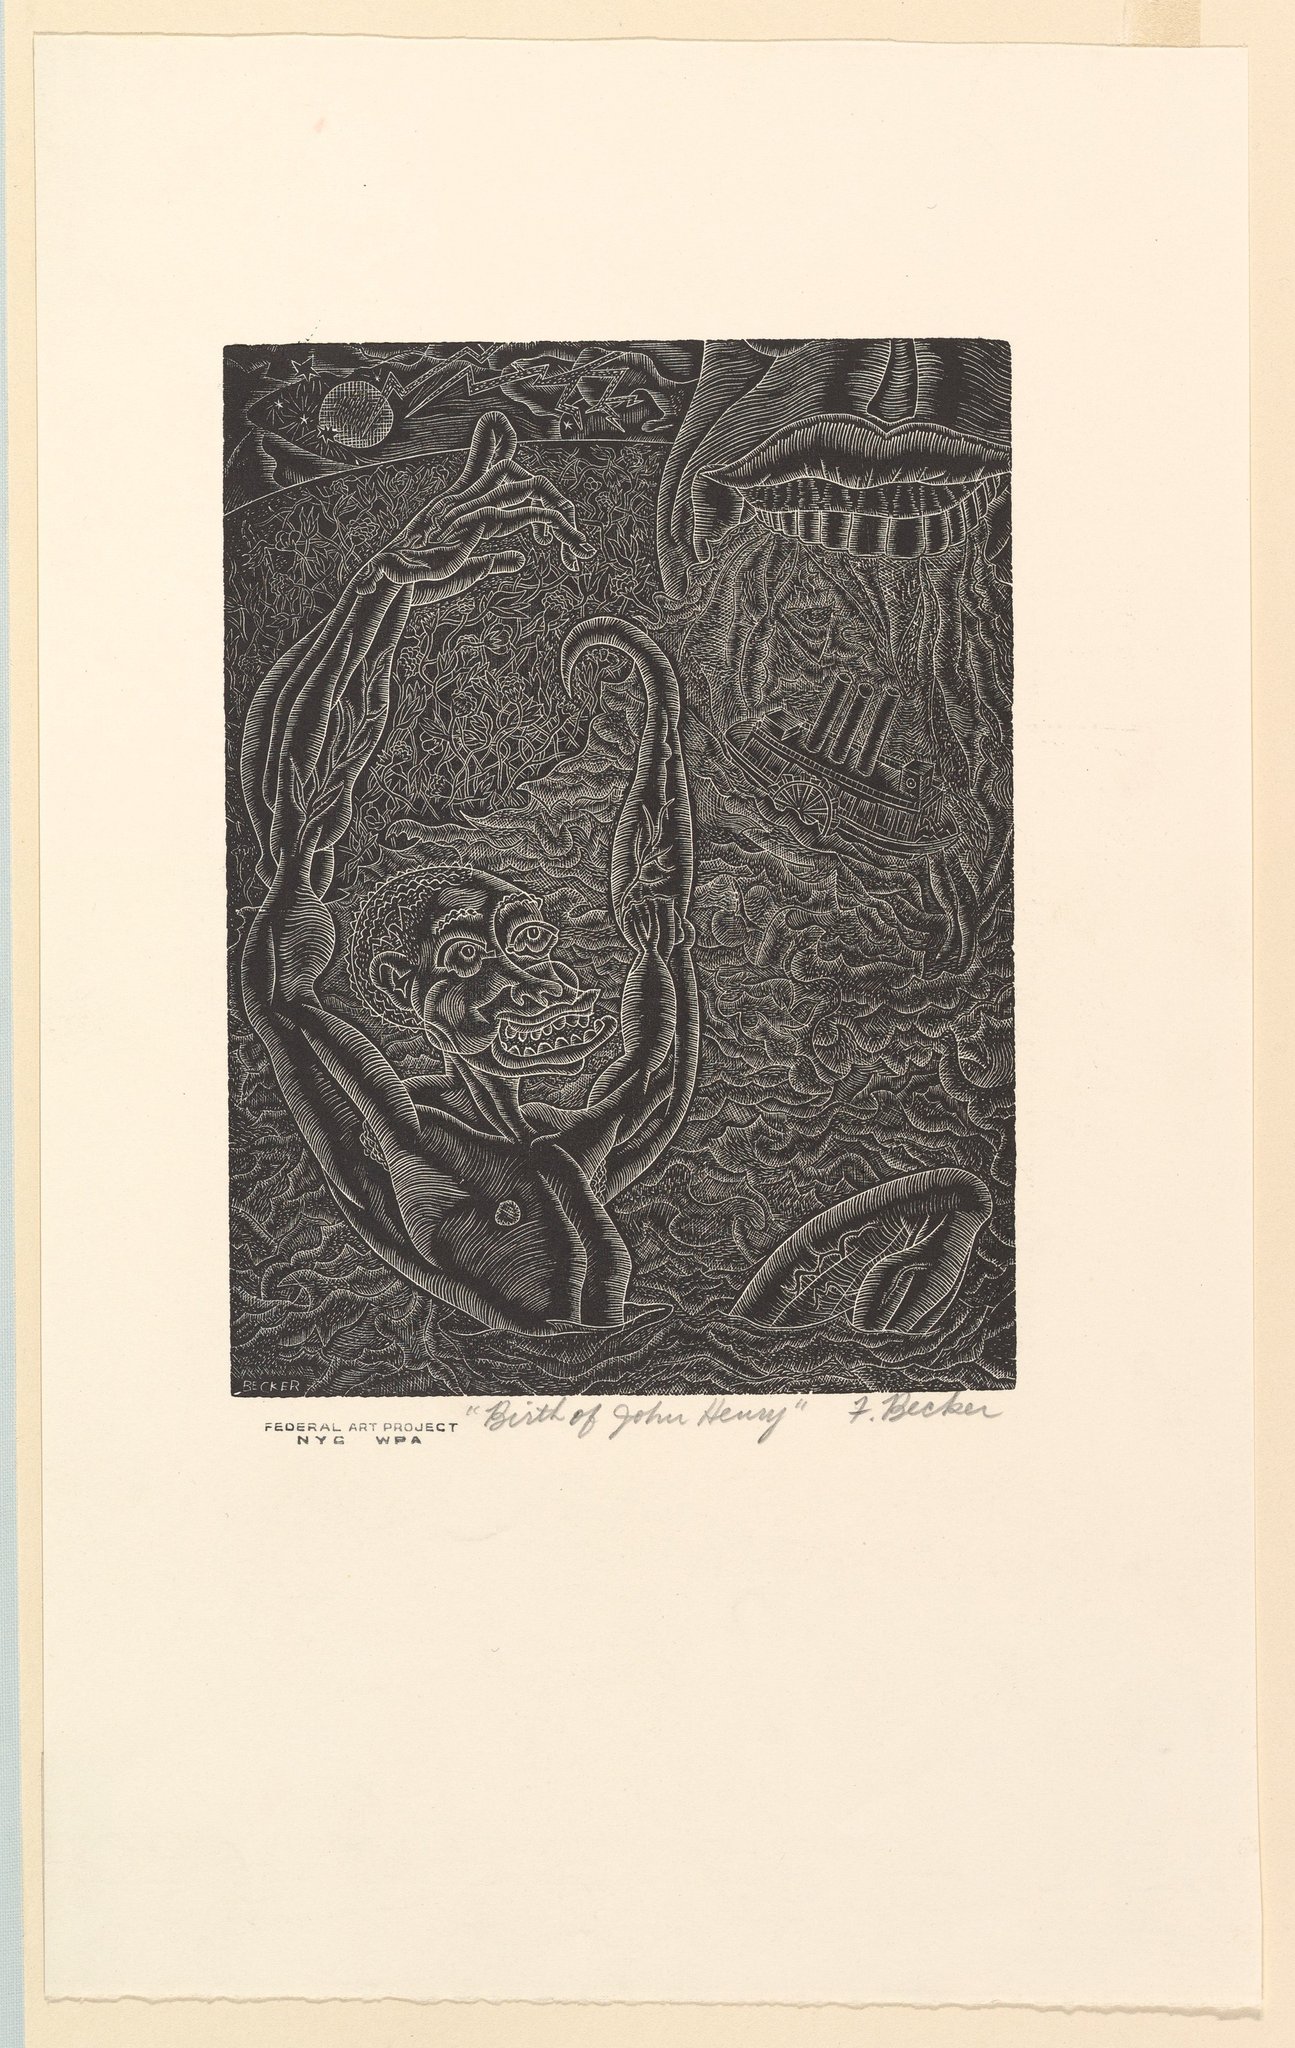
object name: print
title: Birth of John Henry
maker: fred becker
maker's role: artist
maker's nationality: american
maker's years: 1913-2004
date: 1935-1940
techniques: engraving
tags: men